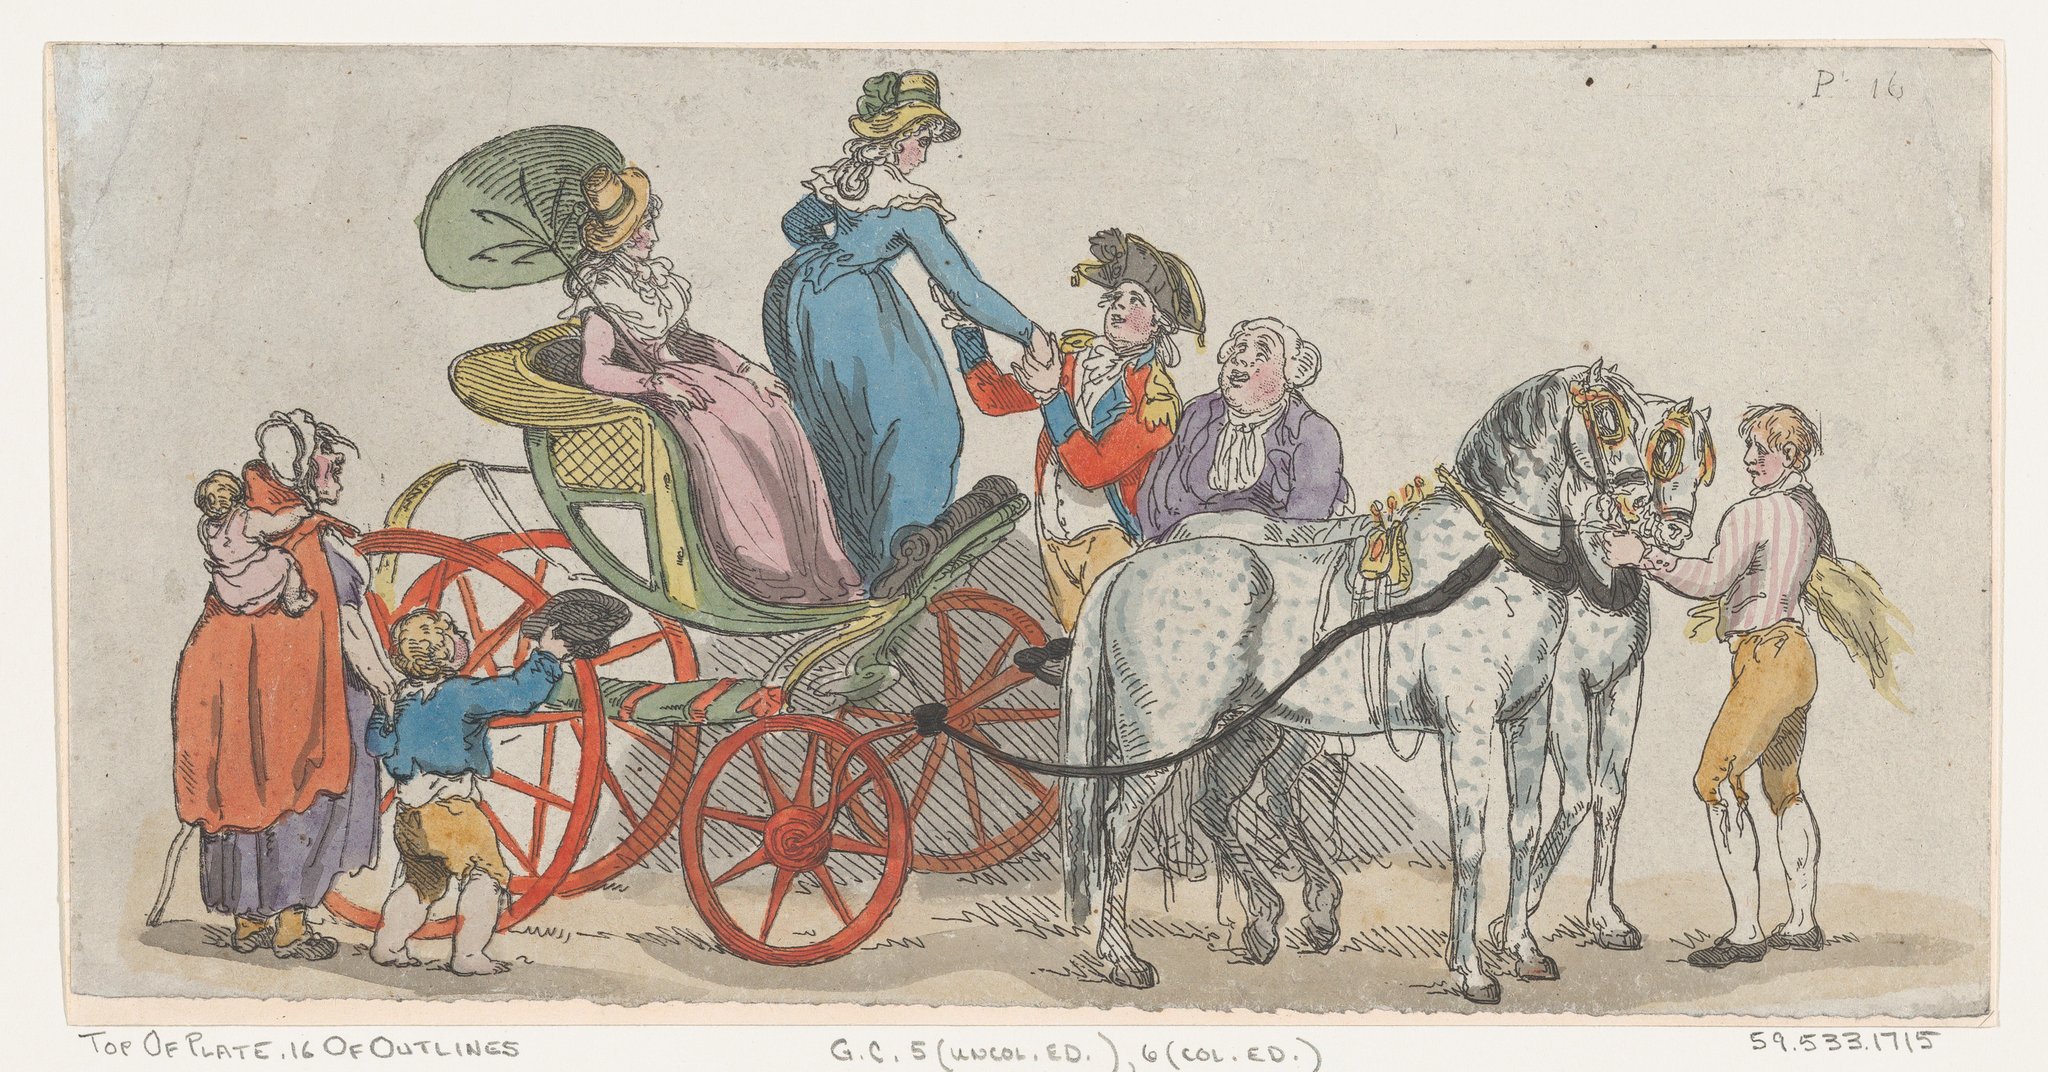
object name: print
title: Ladies Getting Out of a Carriage (from Plate 16, Outlines of Figures, Landscapes and Cattle)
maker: thomas rowlandson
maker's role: artist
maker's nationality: british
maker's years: 1757-1827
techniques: etching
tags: boys,men,women,horses,carriages